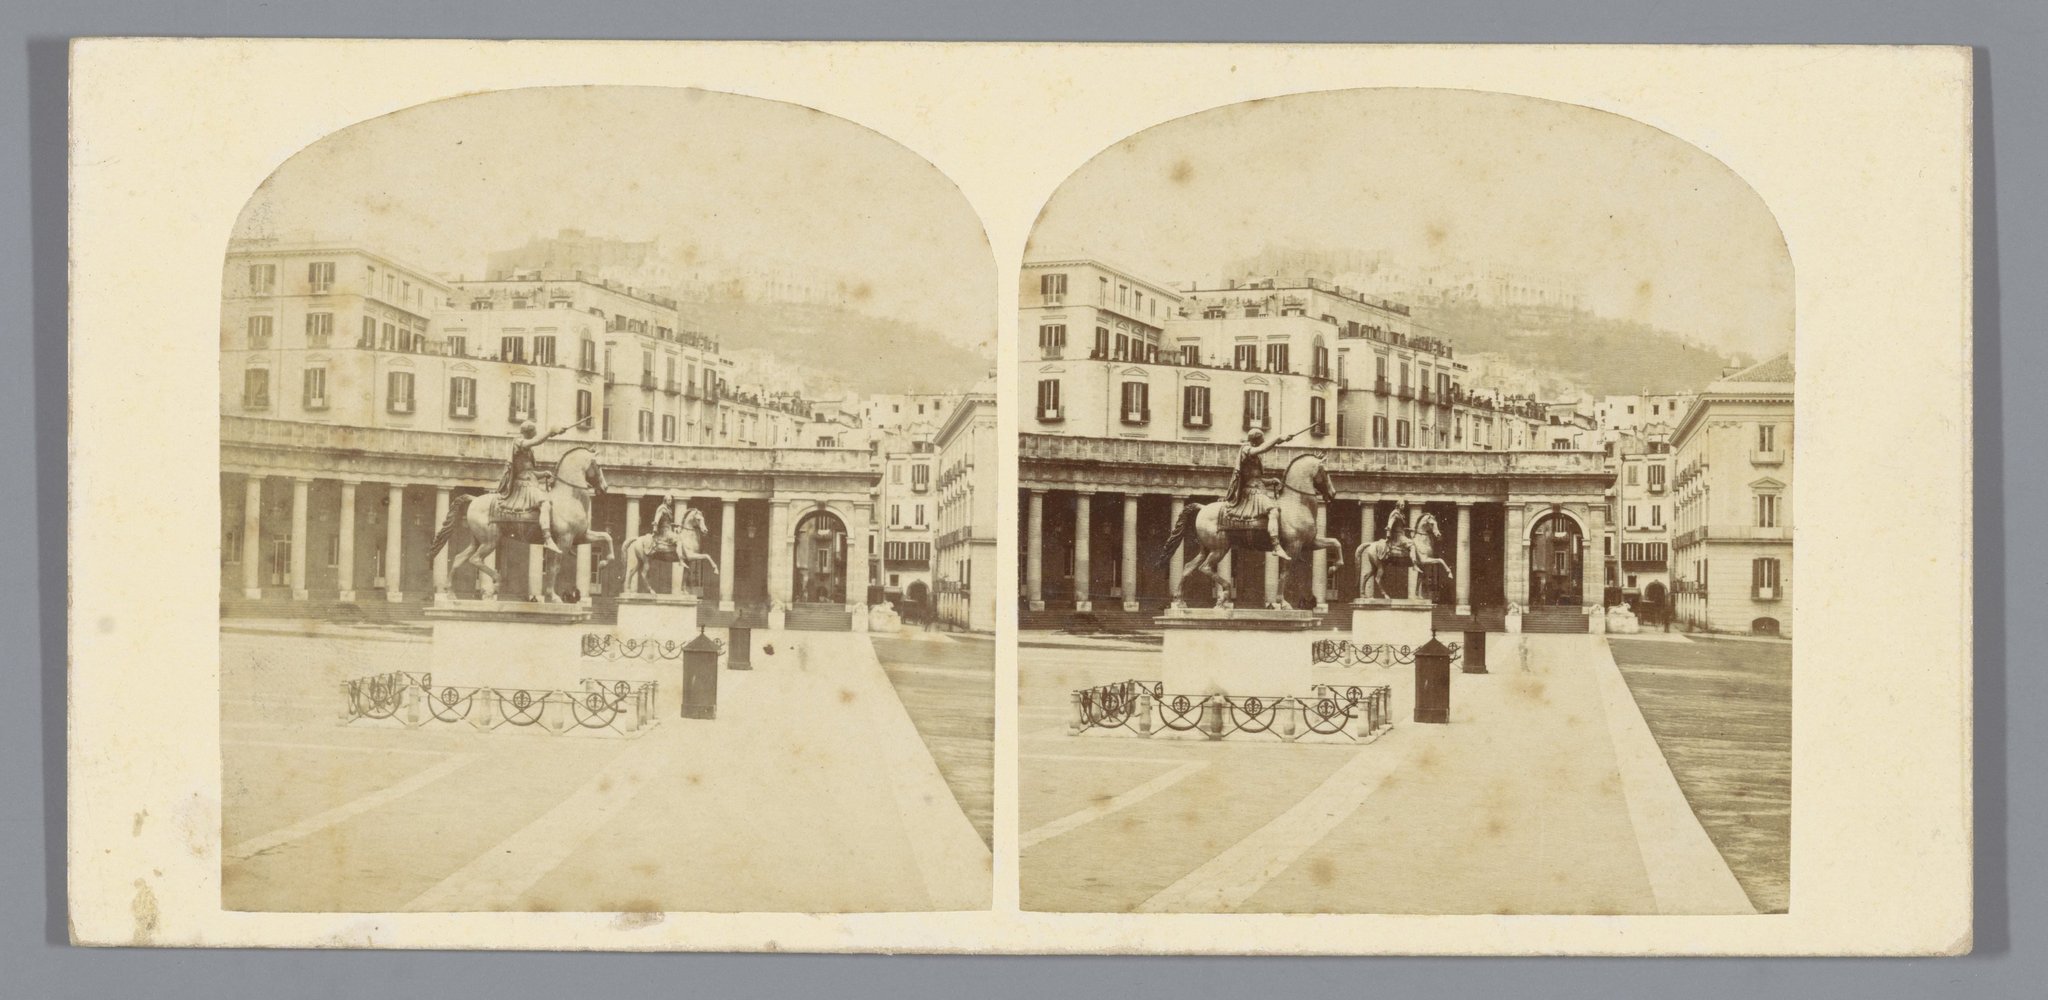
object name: stereograph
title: NAPLES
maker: Anonymous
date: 1850-1880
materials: cardboard, photographic support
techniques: albumen print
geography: piazza del plebiscito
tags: equestrian statue, village square, place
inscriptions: inscription: ‘Place S Ferdinand’